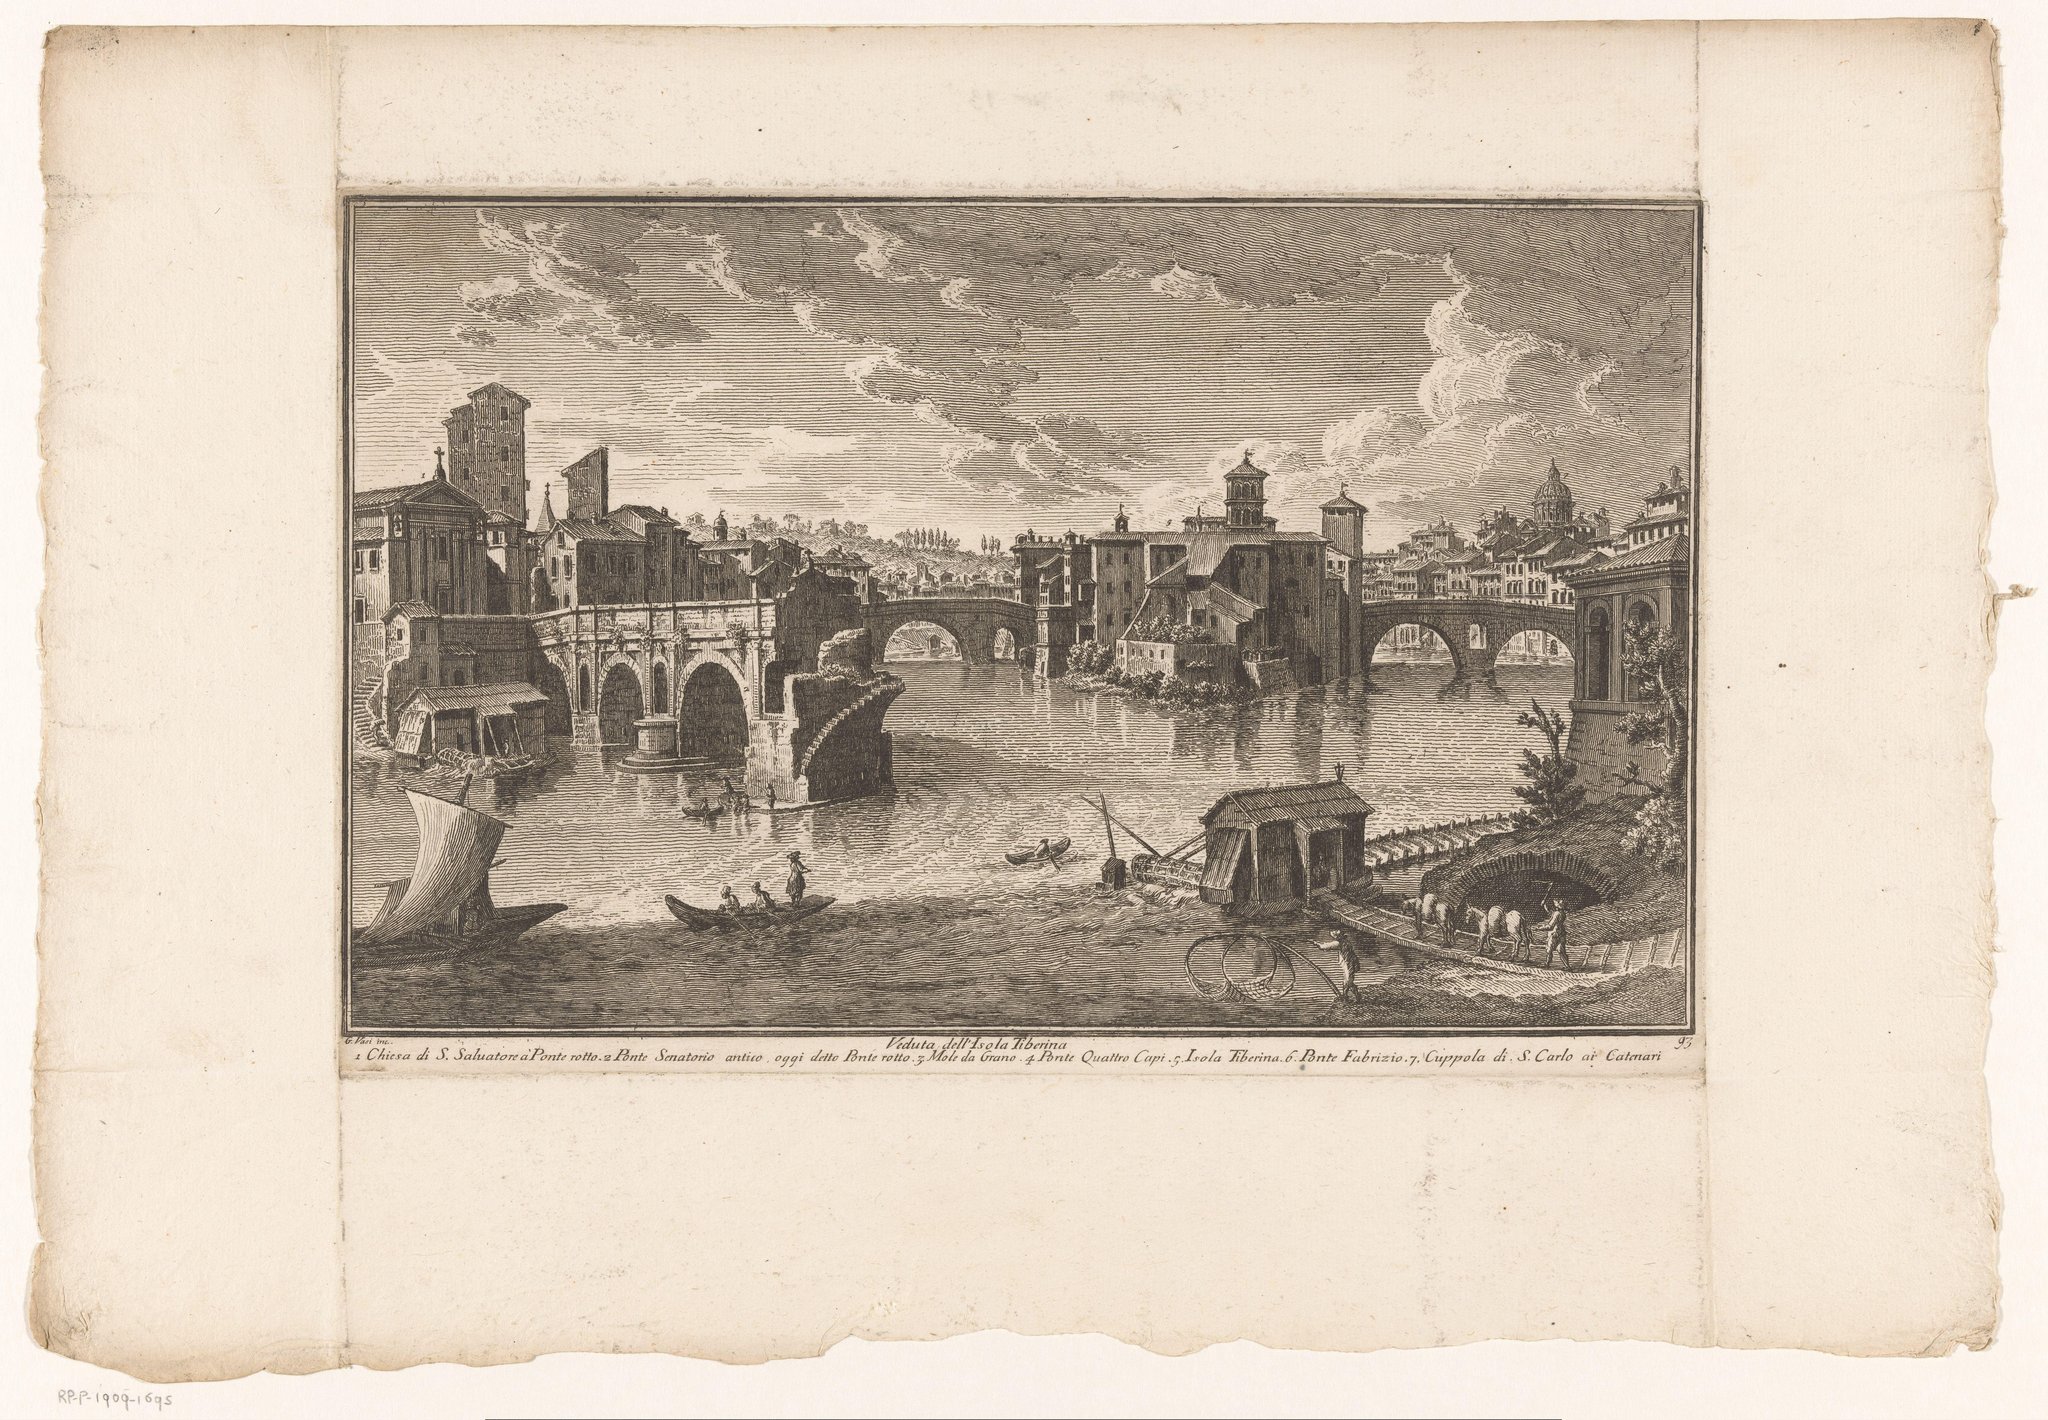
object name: print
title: Delle Magnificenze di Roma Antica e Moderna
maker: giuseppe vasi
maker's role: draughtsman, painter, print maker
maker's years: 1710-1782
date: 1747-1761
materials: paper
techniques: etching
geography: italy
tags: island, city-view in general; 'veduta', rome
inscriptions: collector's mark: Lugt 2228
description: Deze prent maakt deel uit van Giuseppe Vasi's serie gezichten op Rome, getiteld 'Delle Magnificenze di Roma Antica e Moderna'. De serie bestaat uit tien delen met elk twintig prenten en werd gepubliceerd tussen 1747 en 1761.